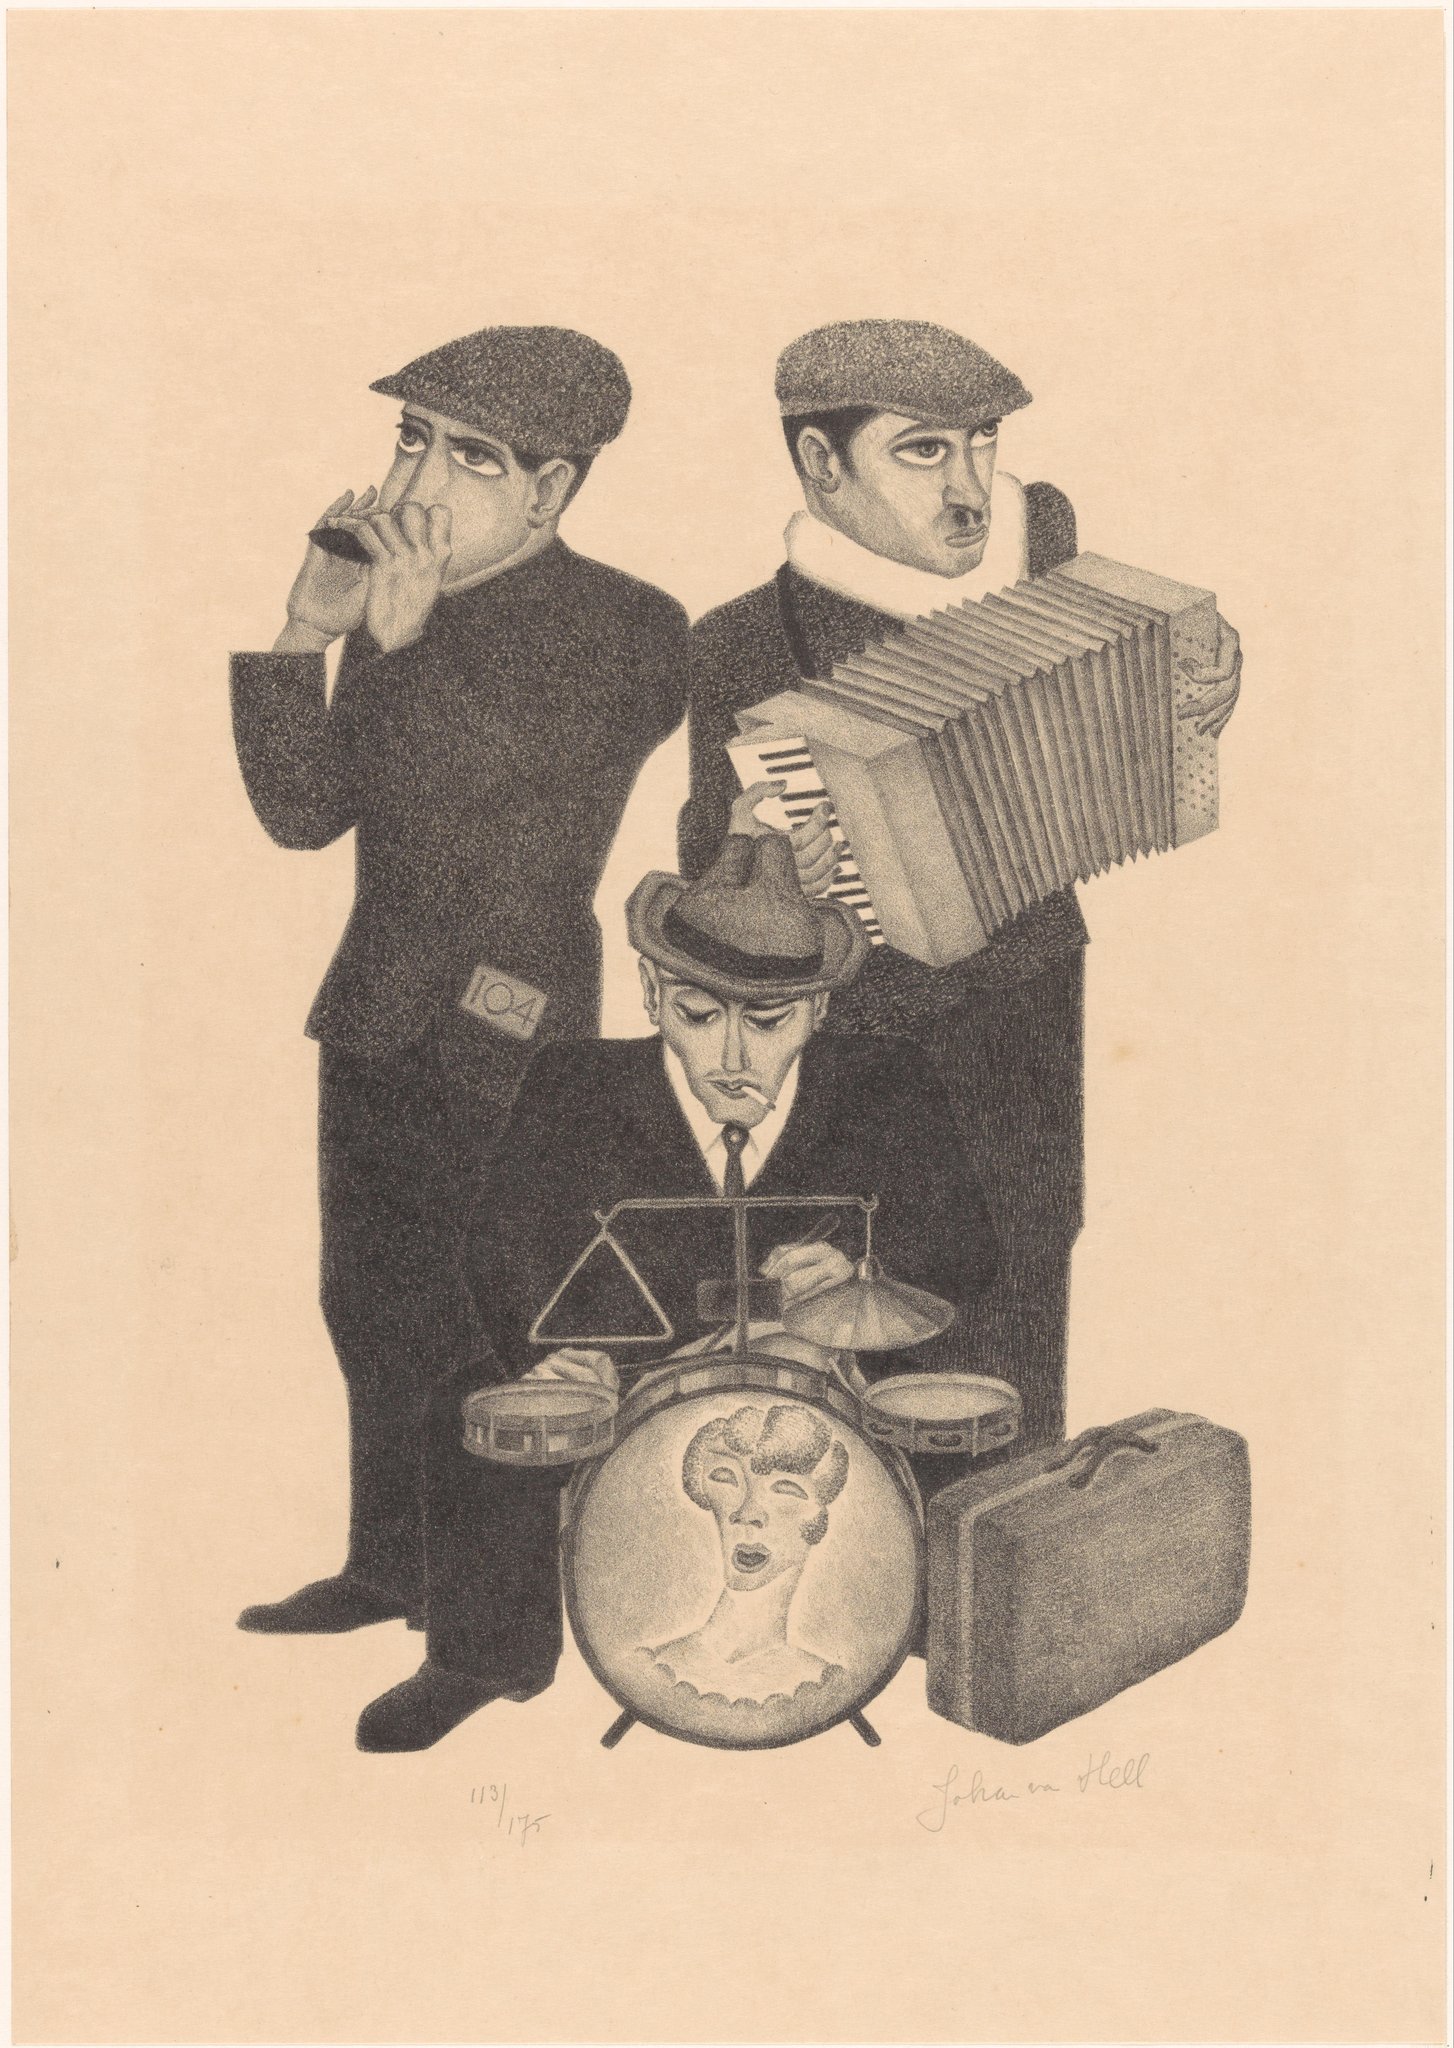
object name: print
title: Straatmuzikanten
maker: johan van hell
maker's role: print maker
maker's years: 1889-1952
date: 1925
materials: paper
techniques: lithograph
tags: musician - cc - out of doors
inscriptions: collector's mark: Lugt 2228, collector's mark: Lugt 2760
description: Een ocarinaspeler, een accordeonist en een drummer op straat. De drummer rookt een sigaret. Op zijn drumstel de beeltenis van een vrouw.